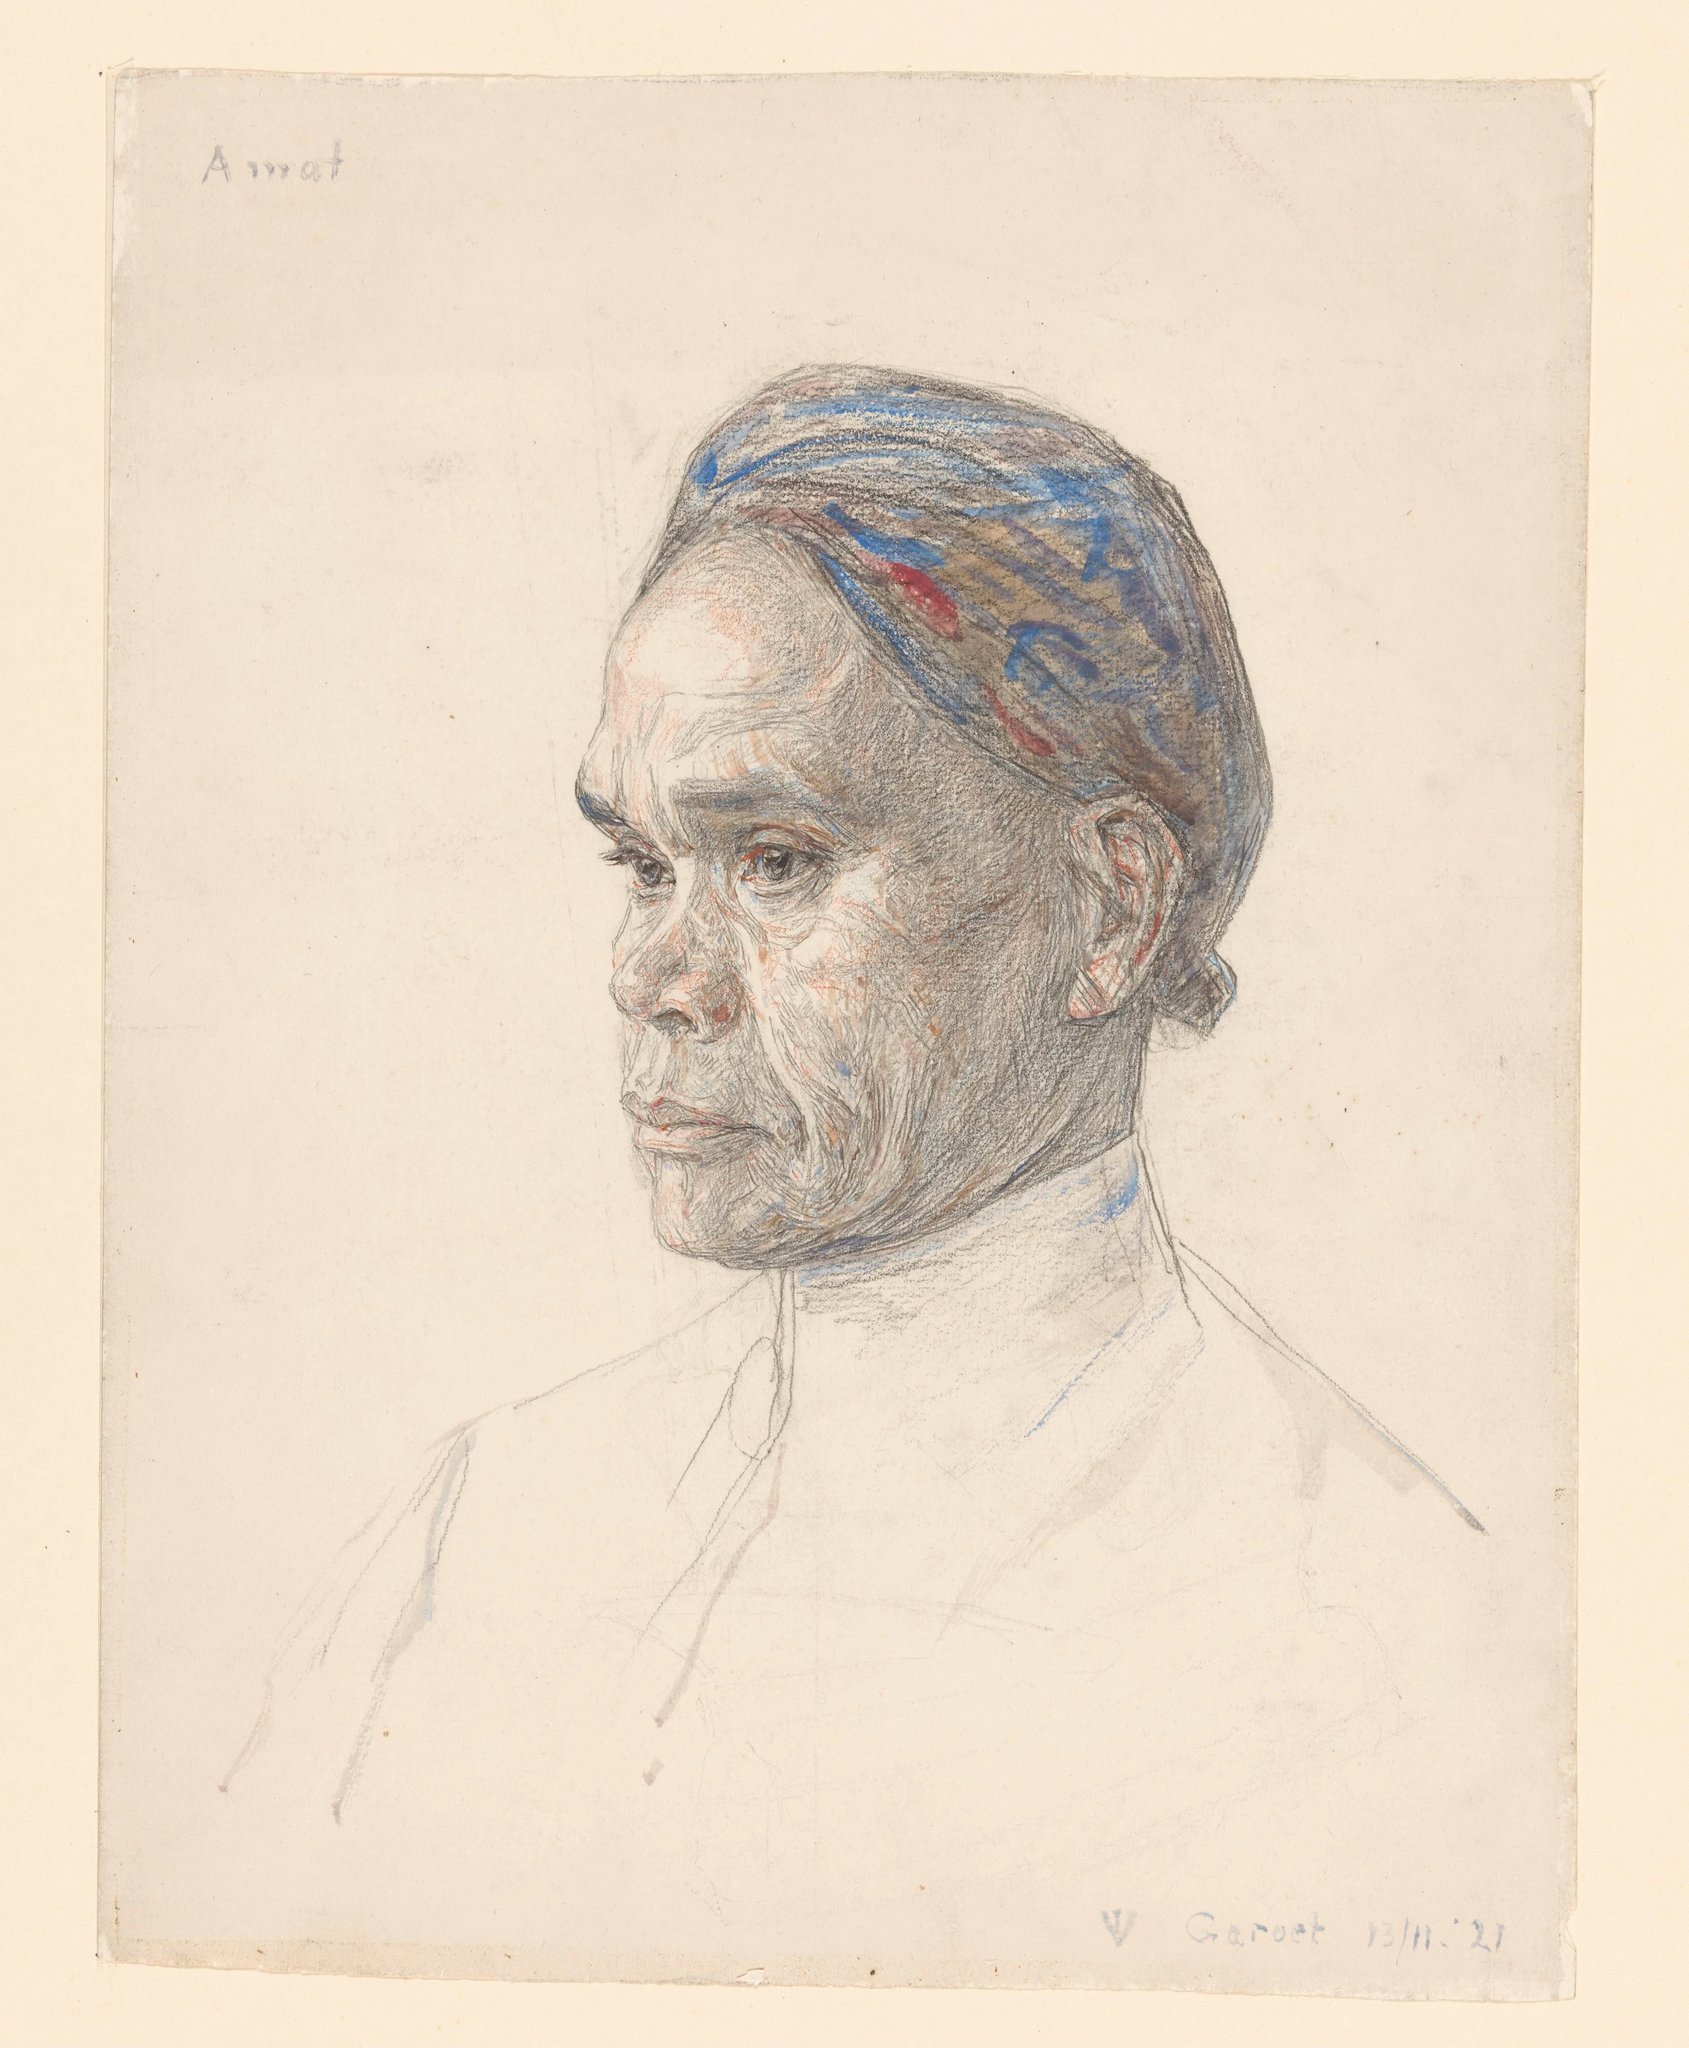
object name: drawing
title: Portret van Amat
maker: jan veth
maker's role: designer, draughtsman, painter, print maker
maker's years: 1864-1925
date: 1921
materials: chalk, paper, pencil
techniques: brush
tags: asiatic races and peoples (indonesians)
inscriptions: inscription: ‘Garoet’